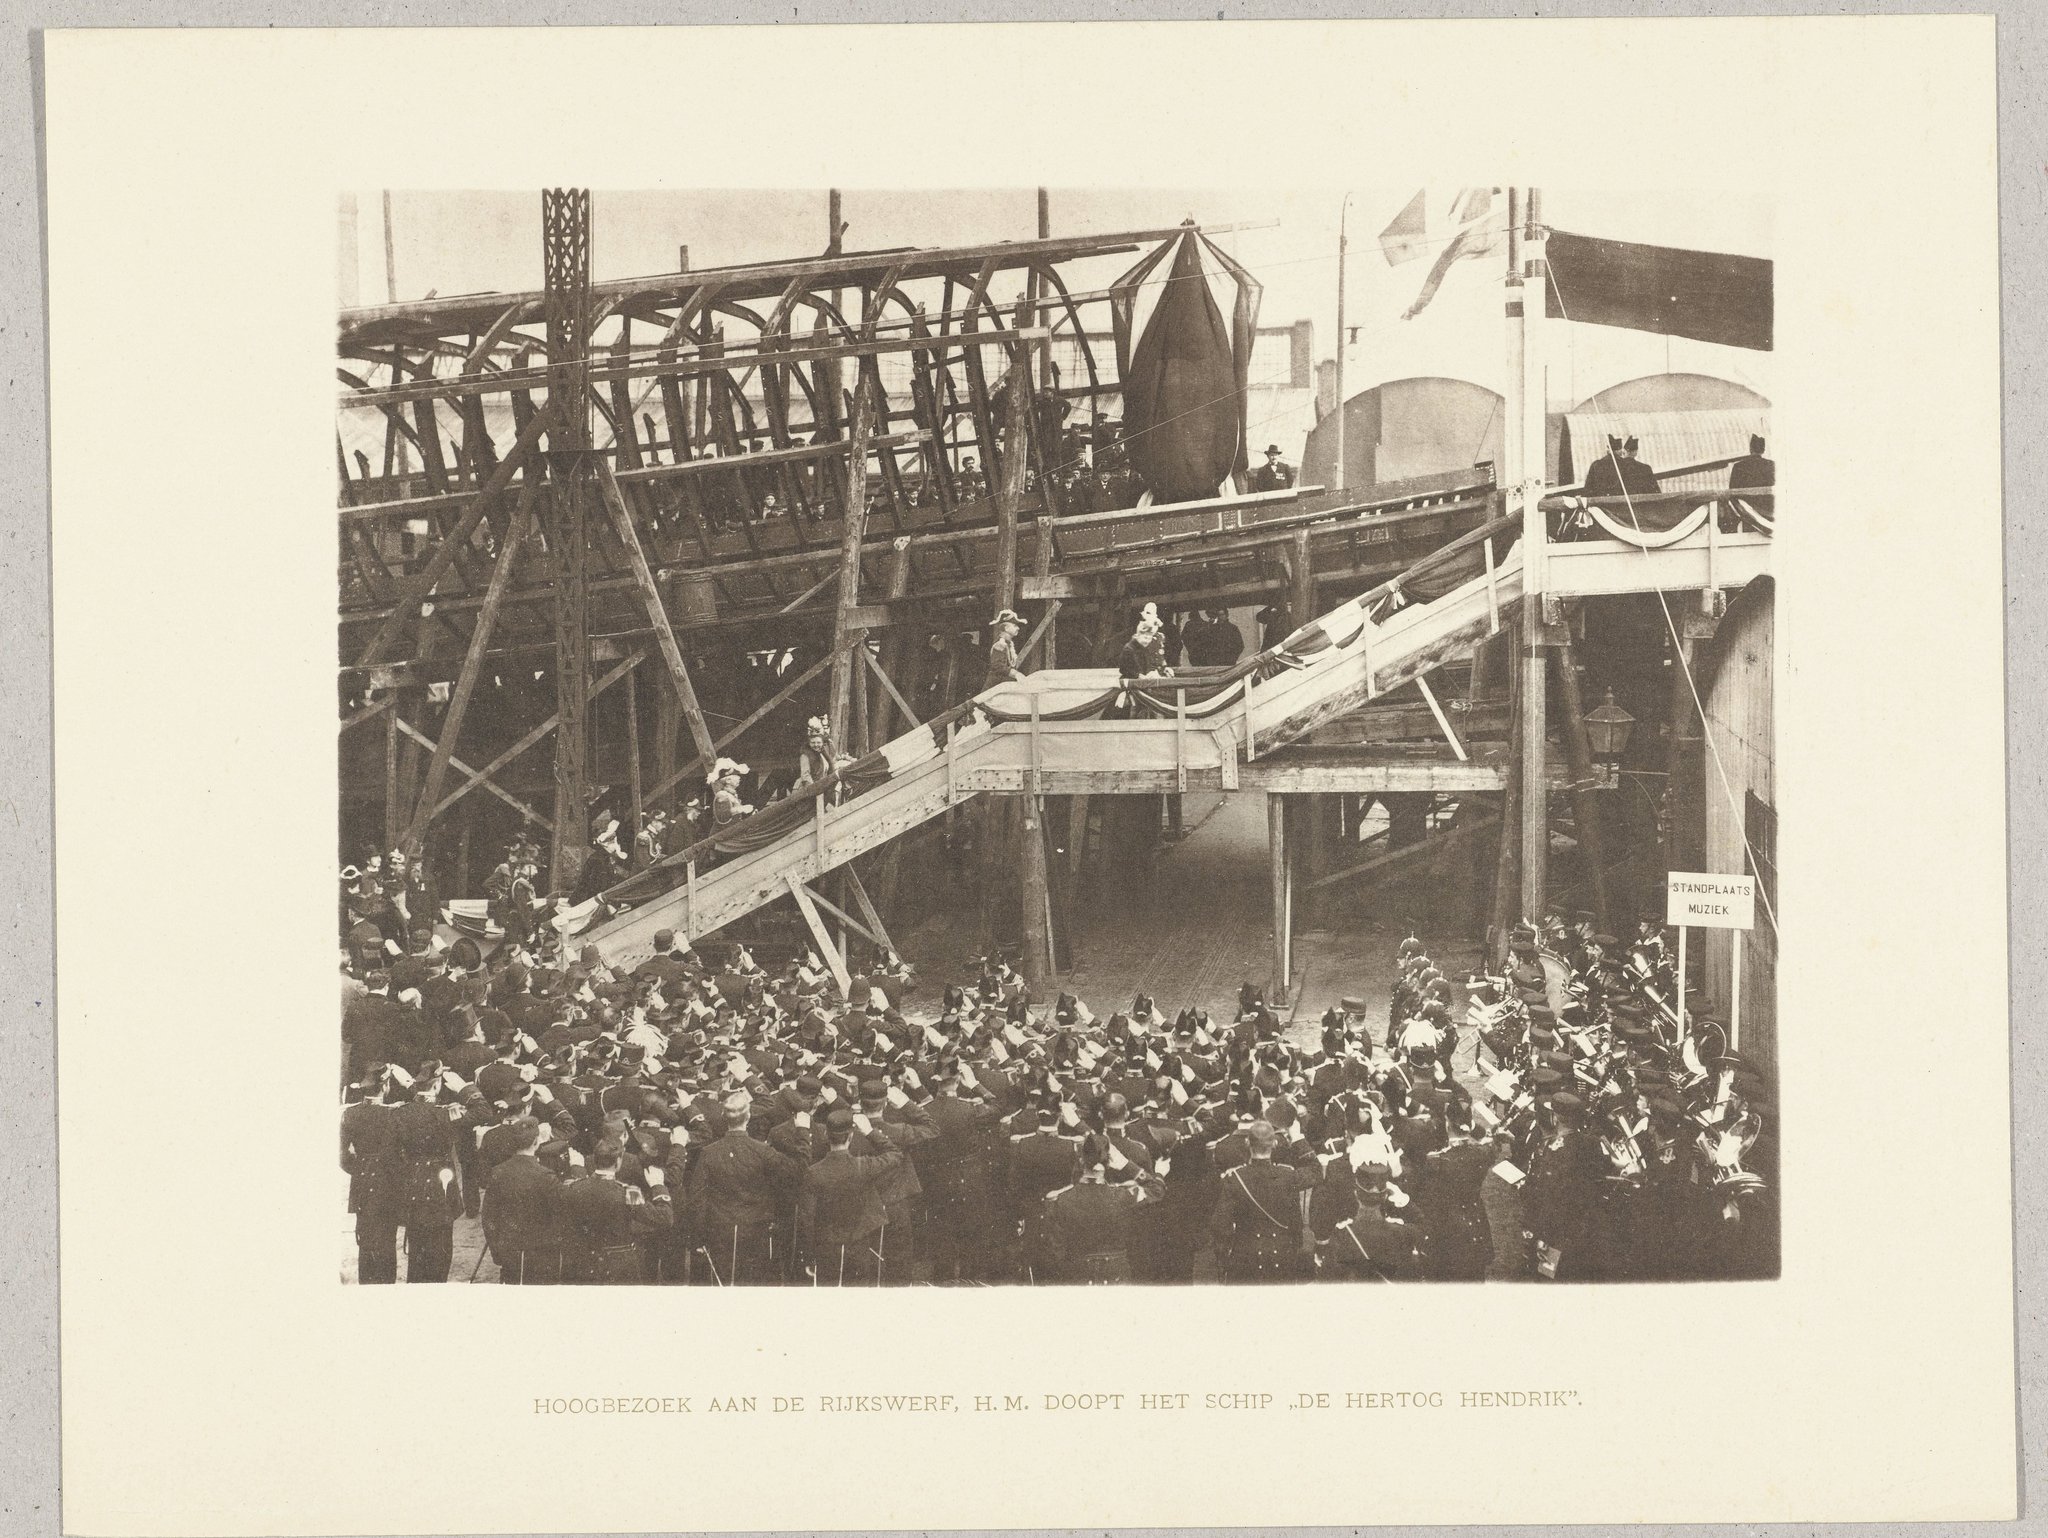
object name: photograph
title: Hoogbezoek aan de Rijkswerf, H.M. doopt het schip "De Hertog Hendrik".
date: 1901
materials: paper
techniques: photograph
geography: amsterdam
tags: the hague, print maker, wilhelmina of the netherlands, ships (in general), pier, quay, wharf, historical events and situations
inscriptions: annotation: ‘Hoogbezoek aan de Rijkswerf, H.M. doopt het schip "De Hertog Hendrik".’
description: 5 maart 1901, feestelijkheden ter gelegenheid van het huwelijk van koningin Wilhelmina en prins Hendrik